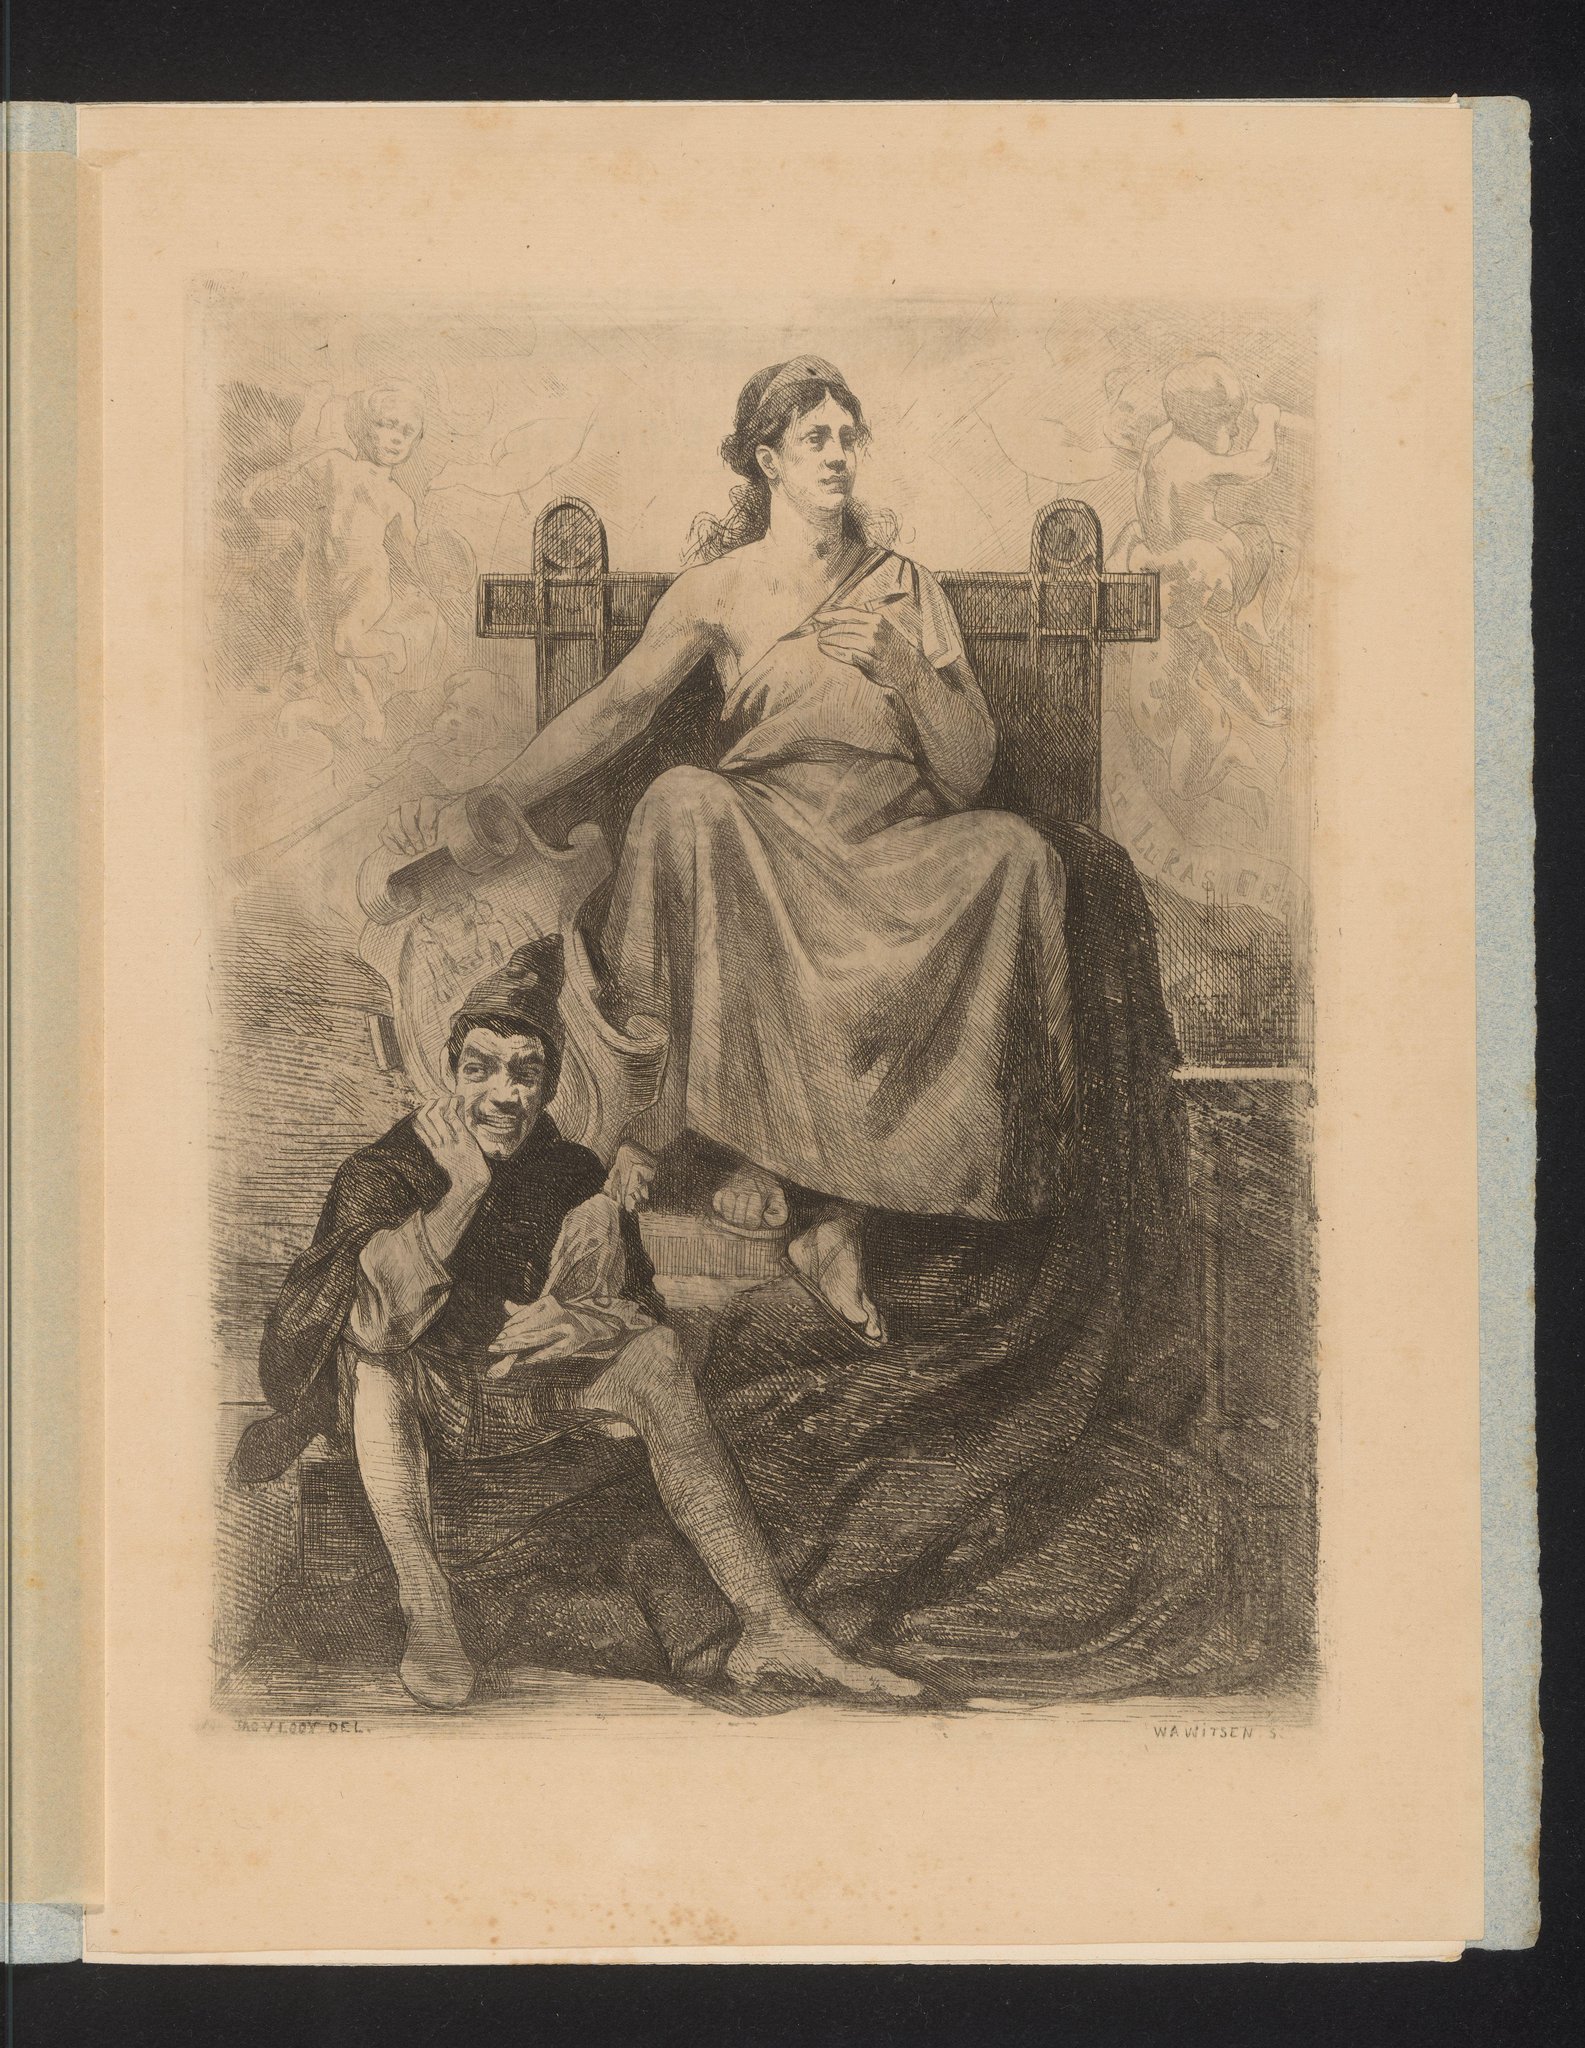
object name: print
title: Vrouw in klassieke kledij zittend op een troon achter een nar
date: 1884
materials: paper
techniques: etching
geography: amsterdam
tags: court jester, court fool, adult woman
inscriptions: watermark: ‘Van Gelder’, collector's mark: Lugt 2228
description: Eerste blad uit programmaboek voor het Sint Lucasfeest van de kunstenaarsvereniging St. Lucas in Amsterdam op 2 februari 1884. De vrouw houdt het schild van Sint Lucas vast.